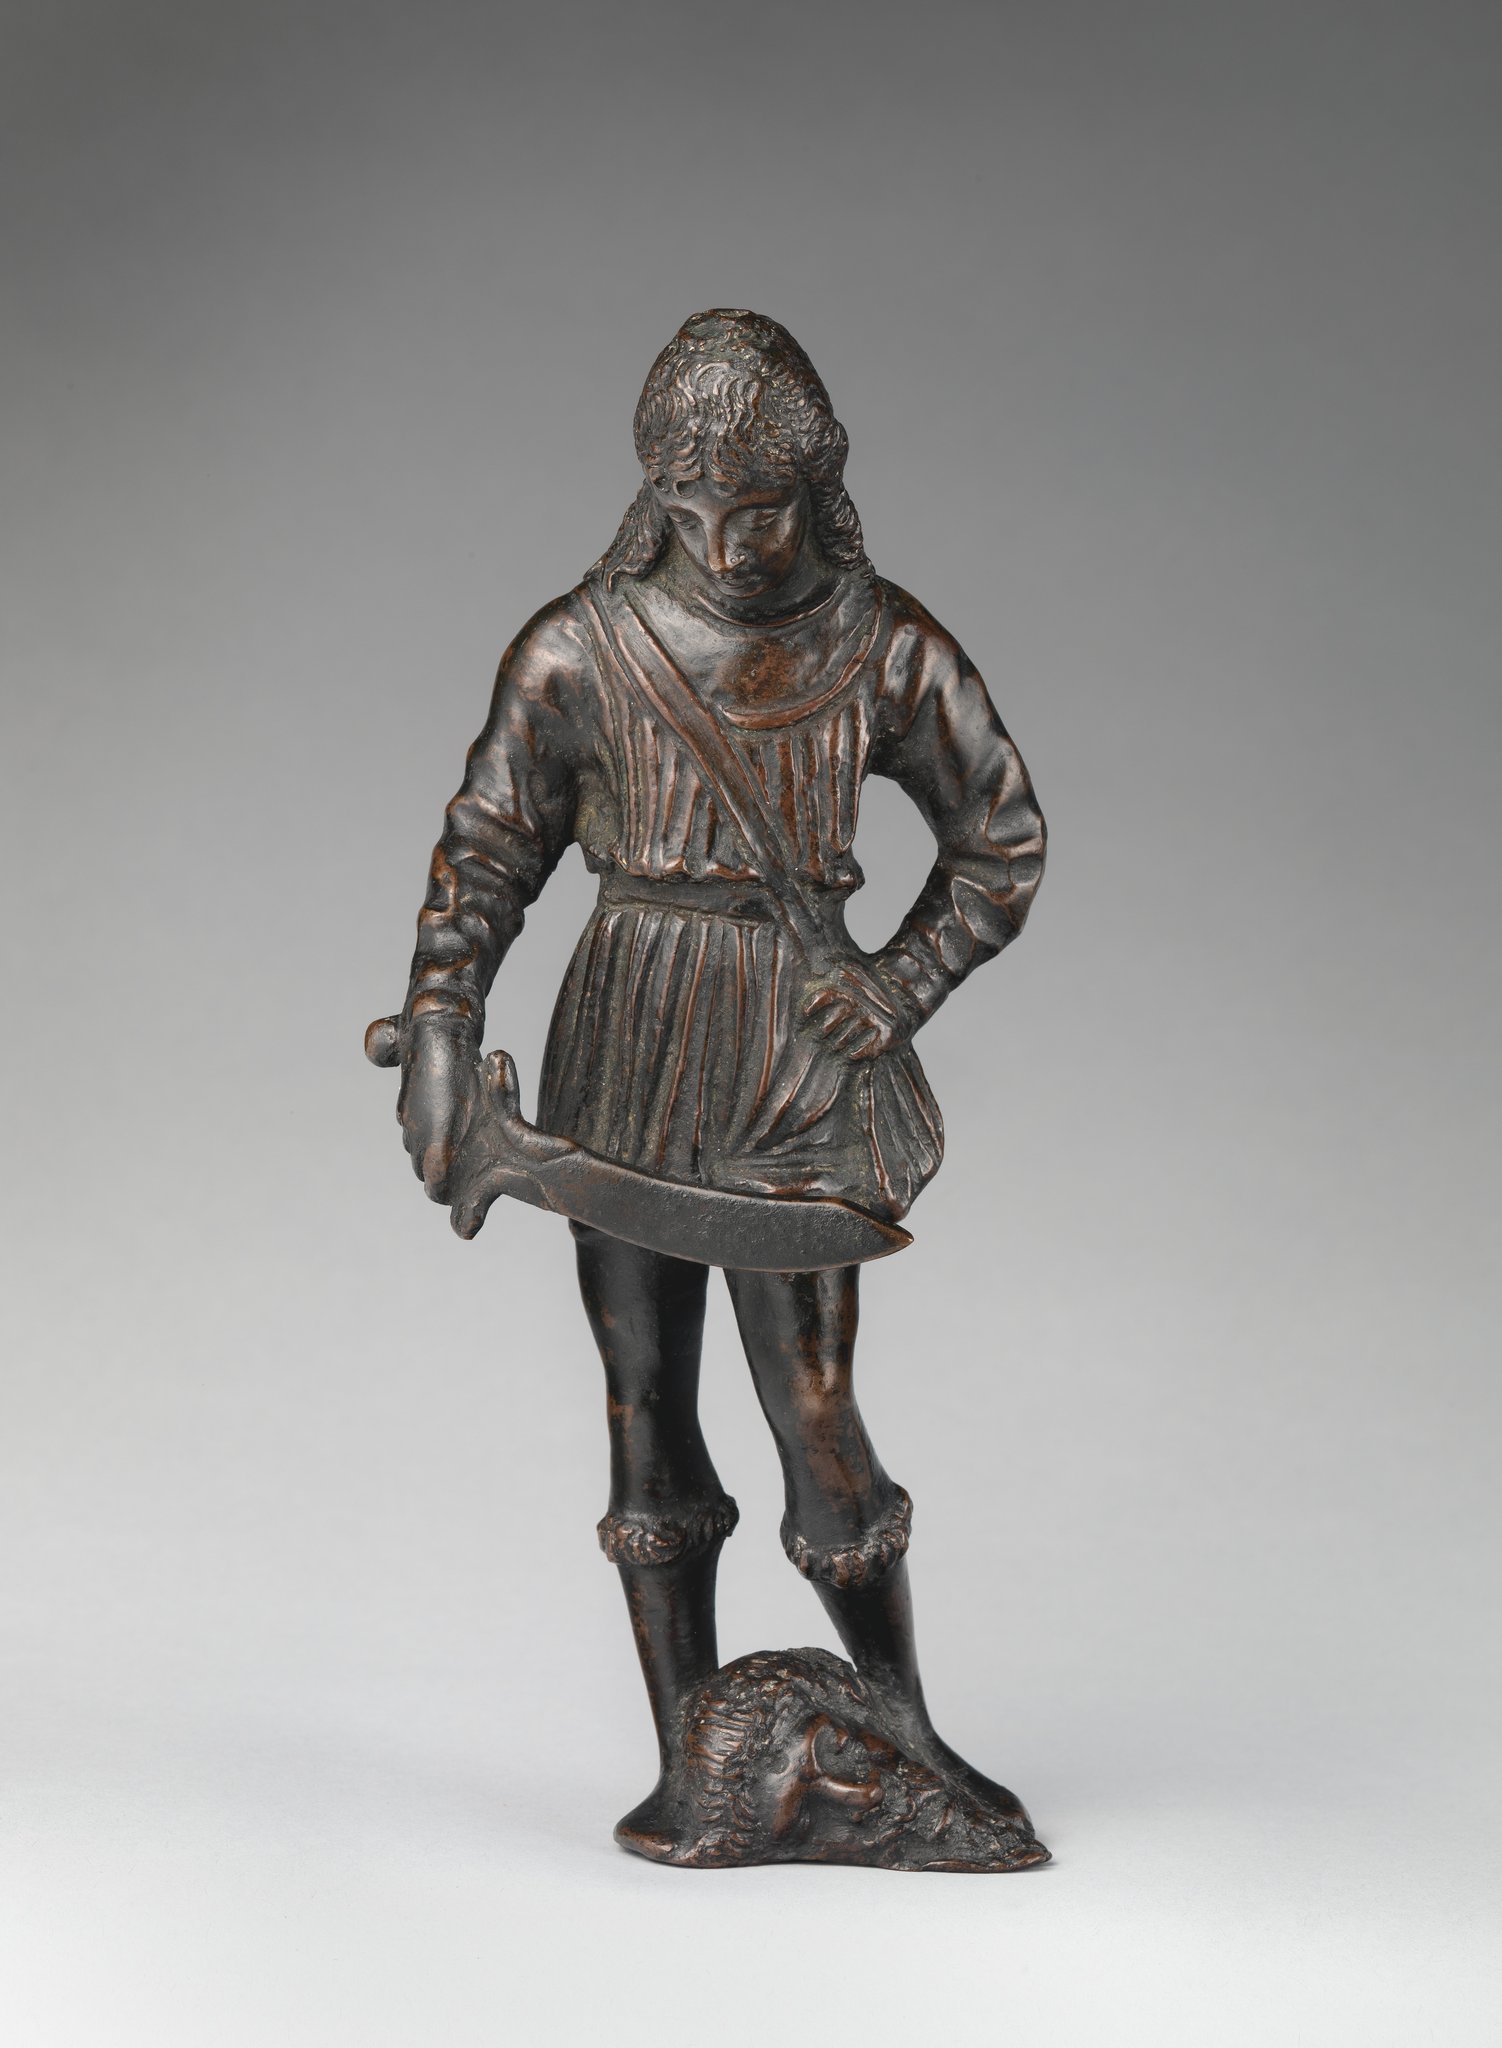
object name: statuette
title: David with the head of Goliath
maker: severo calzetta da ravenna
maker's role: artist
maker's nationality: italian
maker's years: 1496-1543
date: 1534-1566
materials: bronze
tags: swords,heads,david